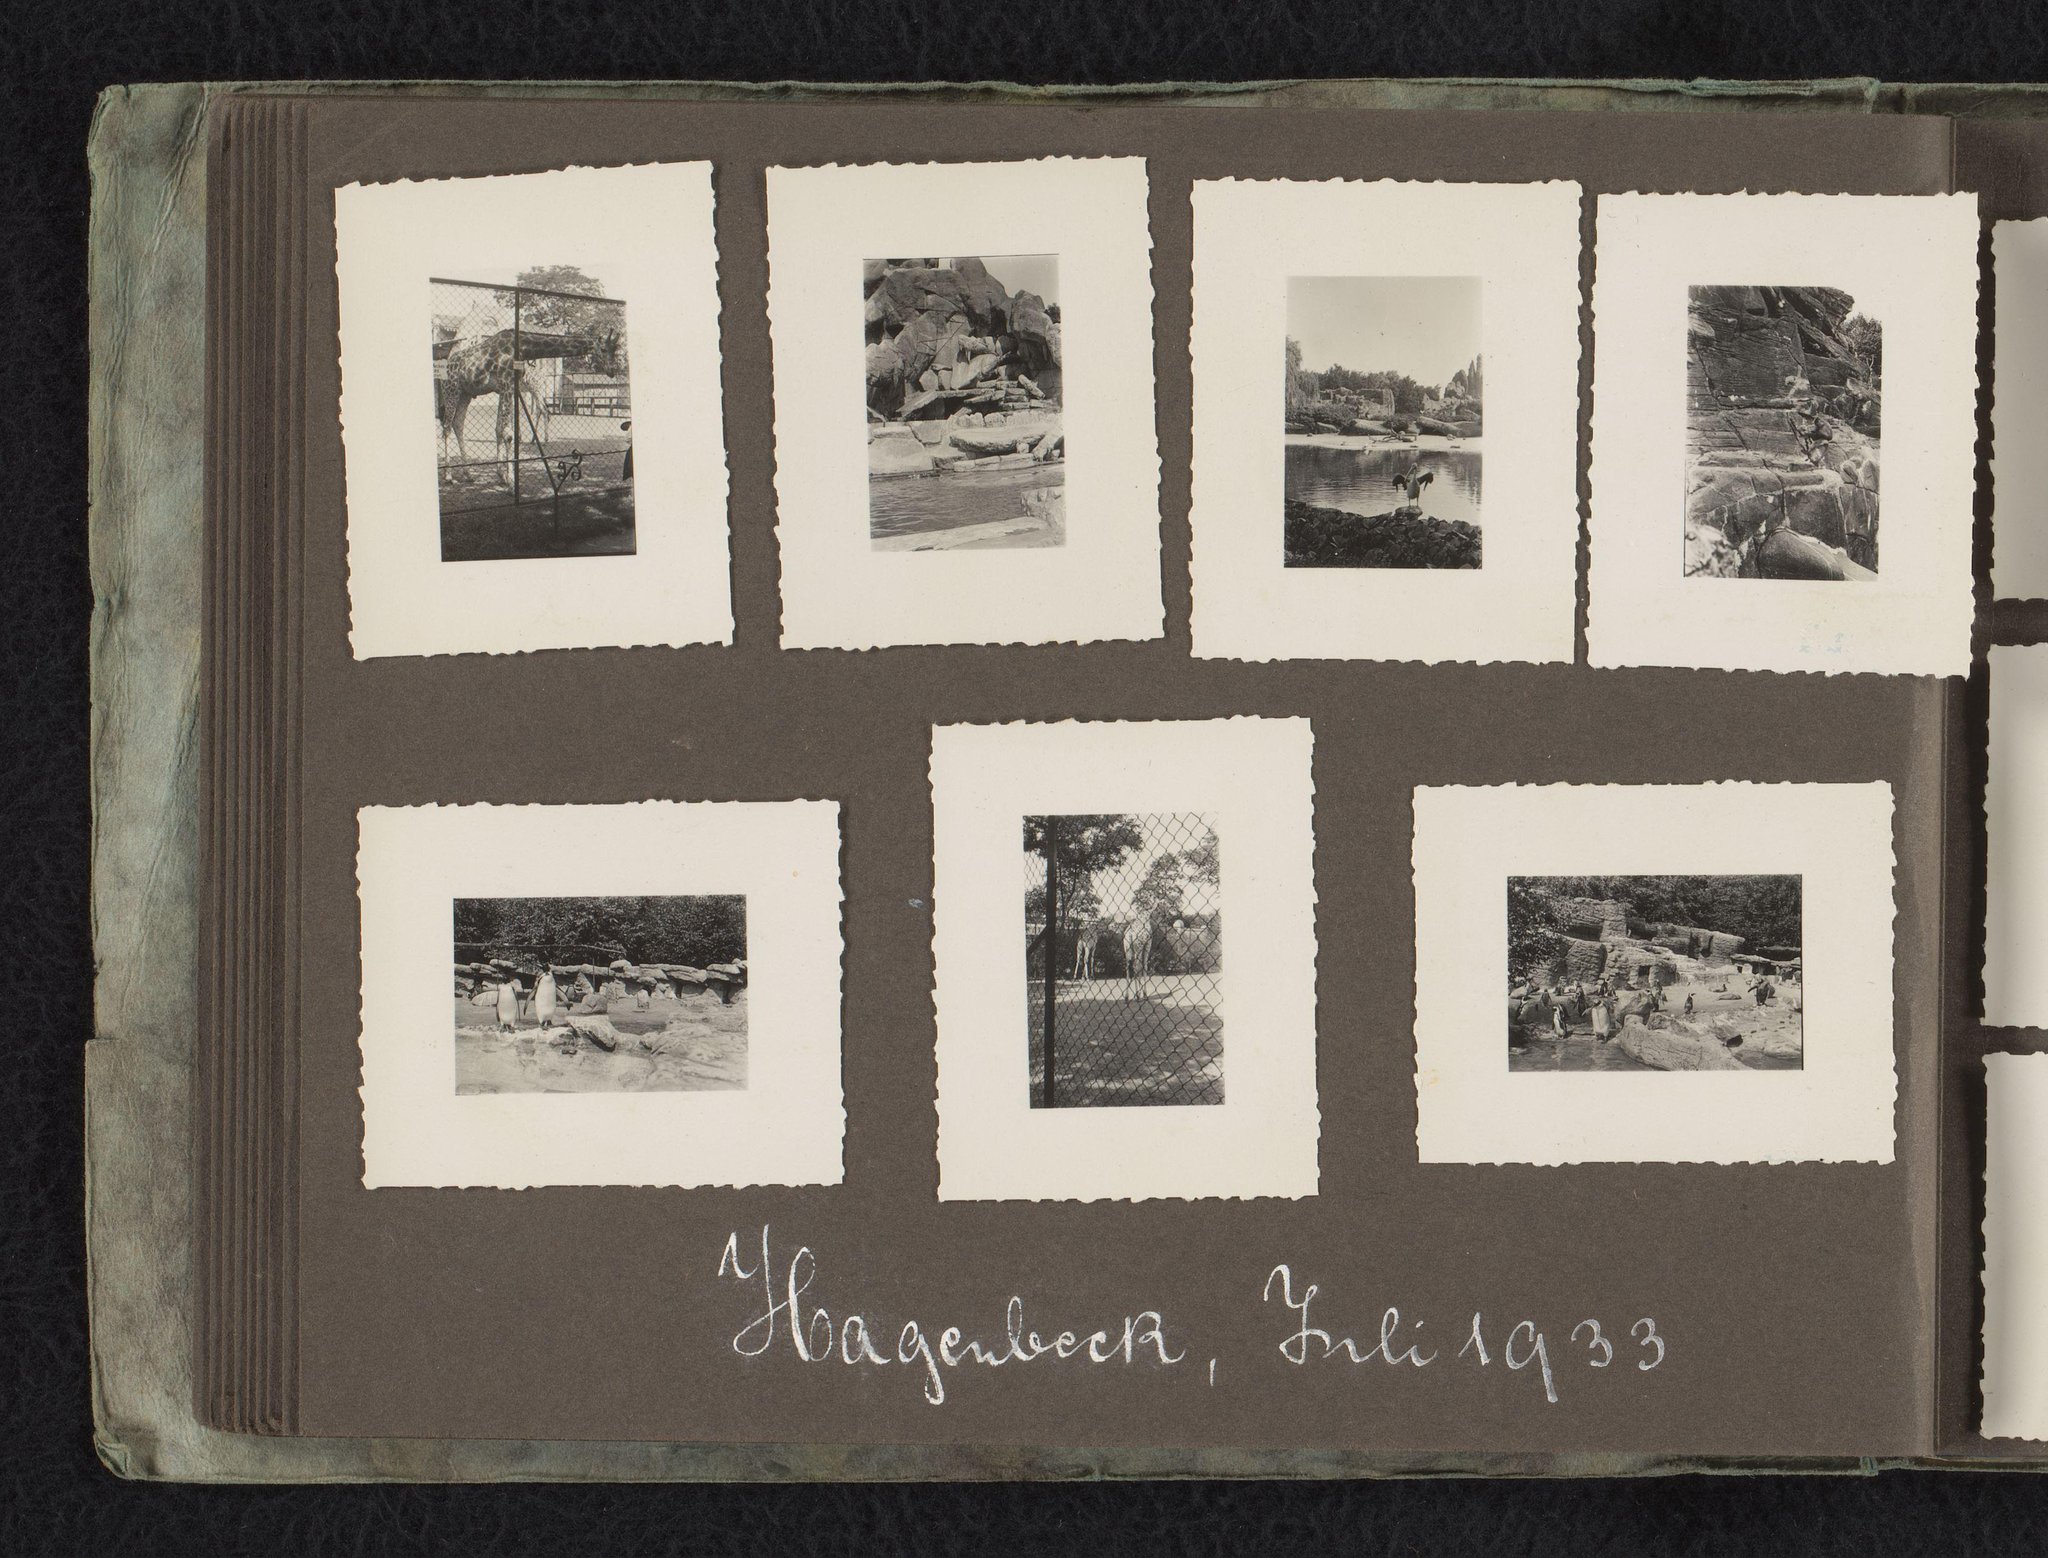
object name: photograph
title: Dieren in dierentuin Hagenbeck, juli 1933, Hamburg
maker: else wachenheimer-moos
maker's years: 1895-1944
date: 1907-1933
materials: paper, photographic support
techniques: gelatin silver print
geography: hamburg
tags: the family travelling, on holiday, zoo (as place of recreation)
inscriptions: inscription: ‘Hagenbeck, Juli 1933’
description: Blad bevat zes foto's. Zonder personen gerelateerd aan de familie Wachenheimer. Uit het album, half formaat, groen geaderd kartonomslag met koordbinding.